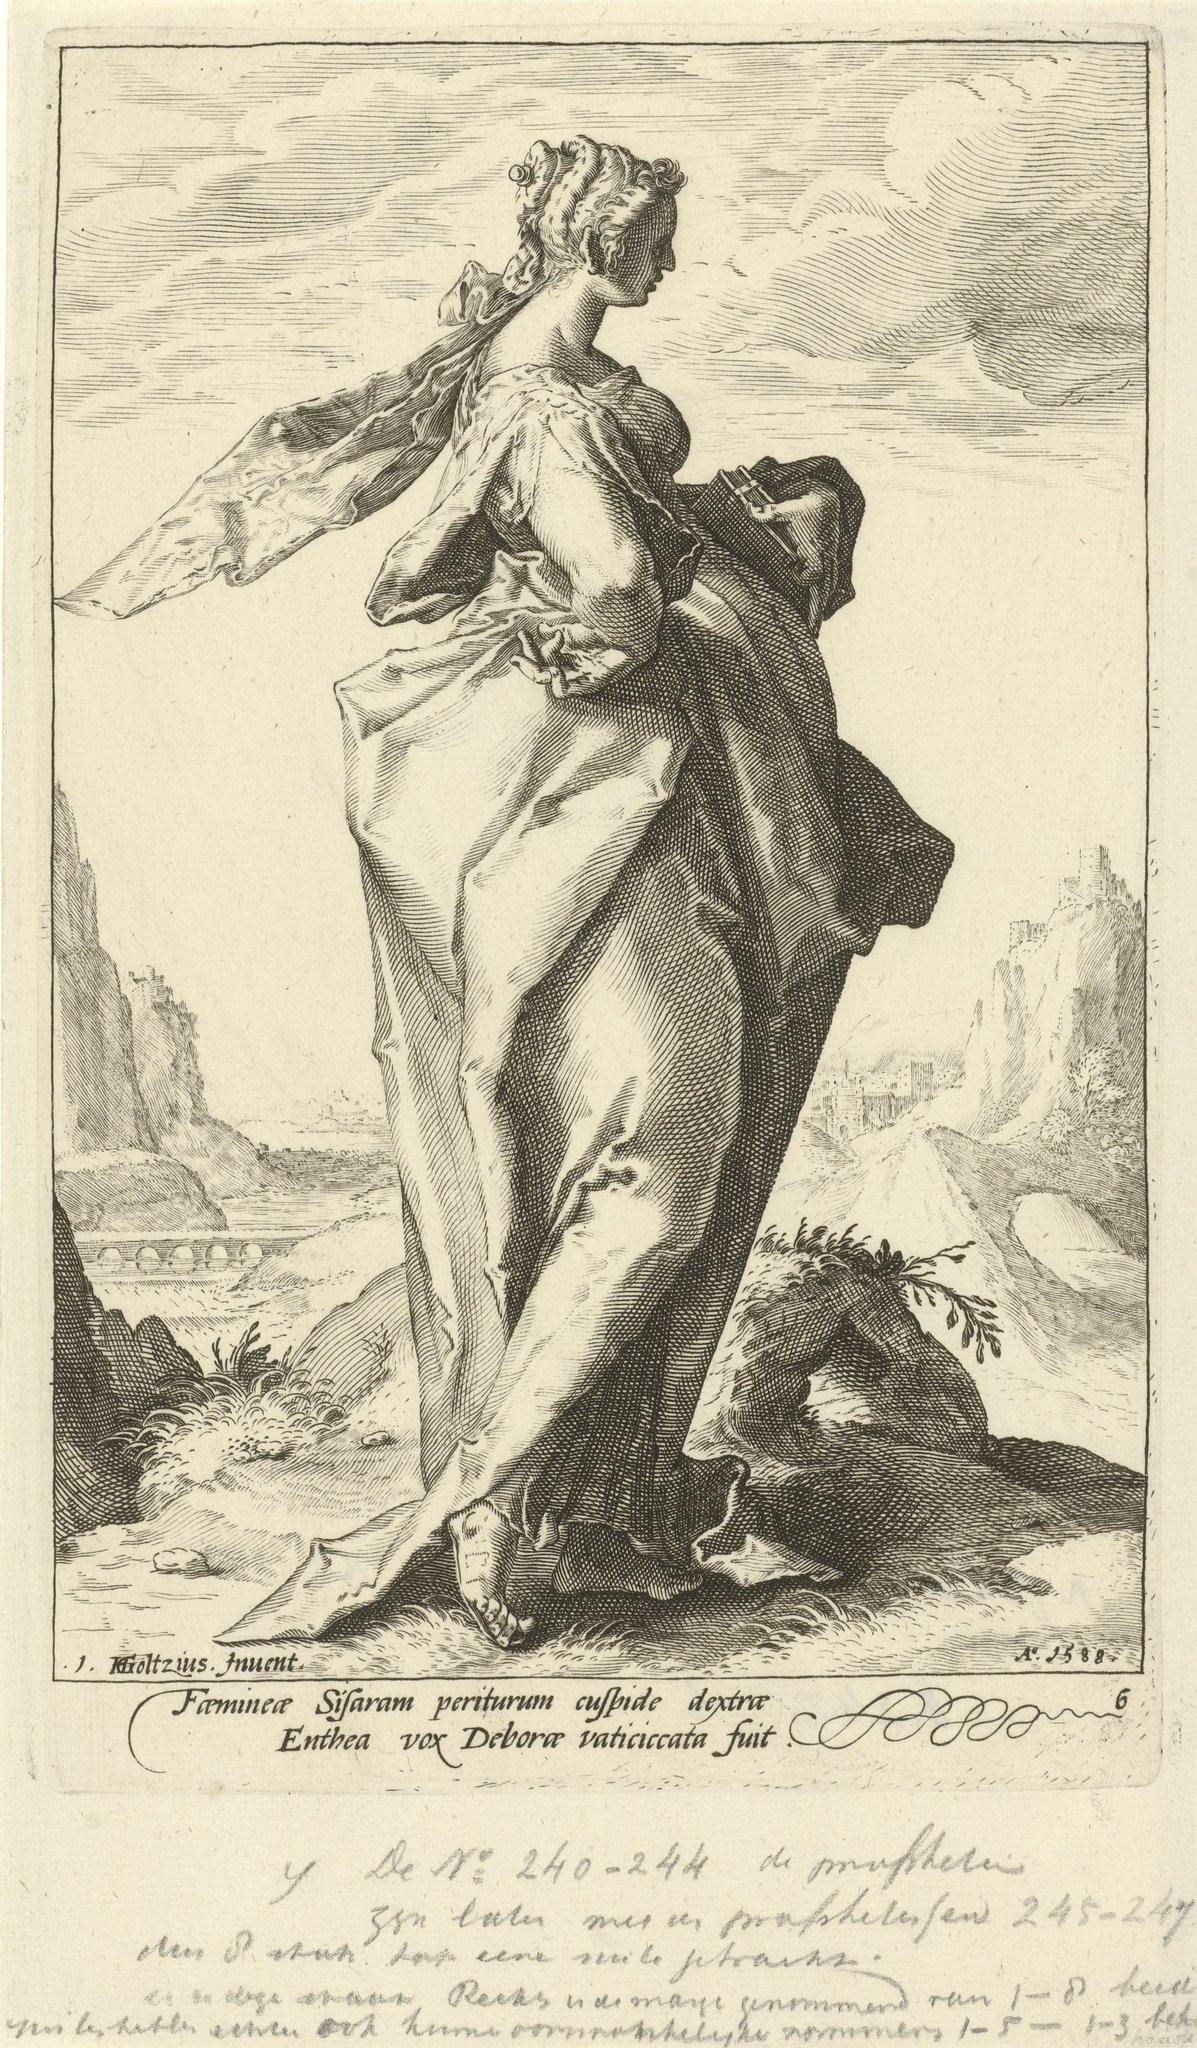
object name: print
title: Profetessen van het Oude Testament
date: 1588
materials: paper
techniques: engraving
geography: amsterdam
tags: the time of deborah and barak (judges 4-5), female persons from the old testament (with name) (not in biblical context)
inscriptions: collector's mark: Lugt 2228, caption: ‘vijf regels in het Nederlands’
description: De profetes Debora, staand met een hand in haar zij en in haar andere hand een boek (het Oude Testament). Zesde prent uit de serie van de profeten en de profetessen uit het Oude Testament samengevoegd.